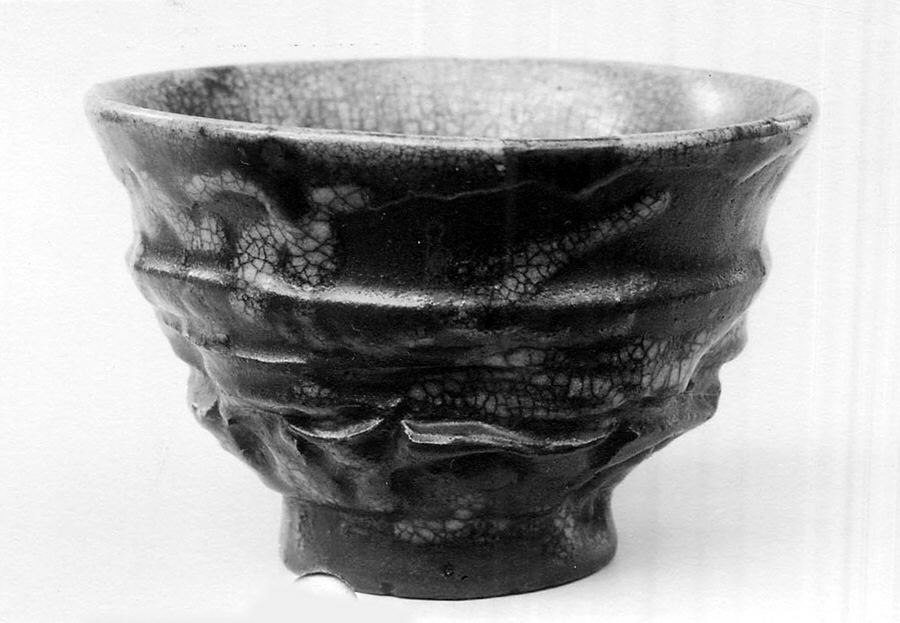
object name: teabowl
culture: japanese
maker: makuzu kōzan i (miyagawa toranosuke)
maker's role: artist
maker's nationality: japanese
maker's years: 1842-1916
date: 1850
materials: clay